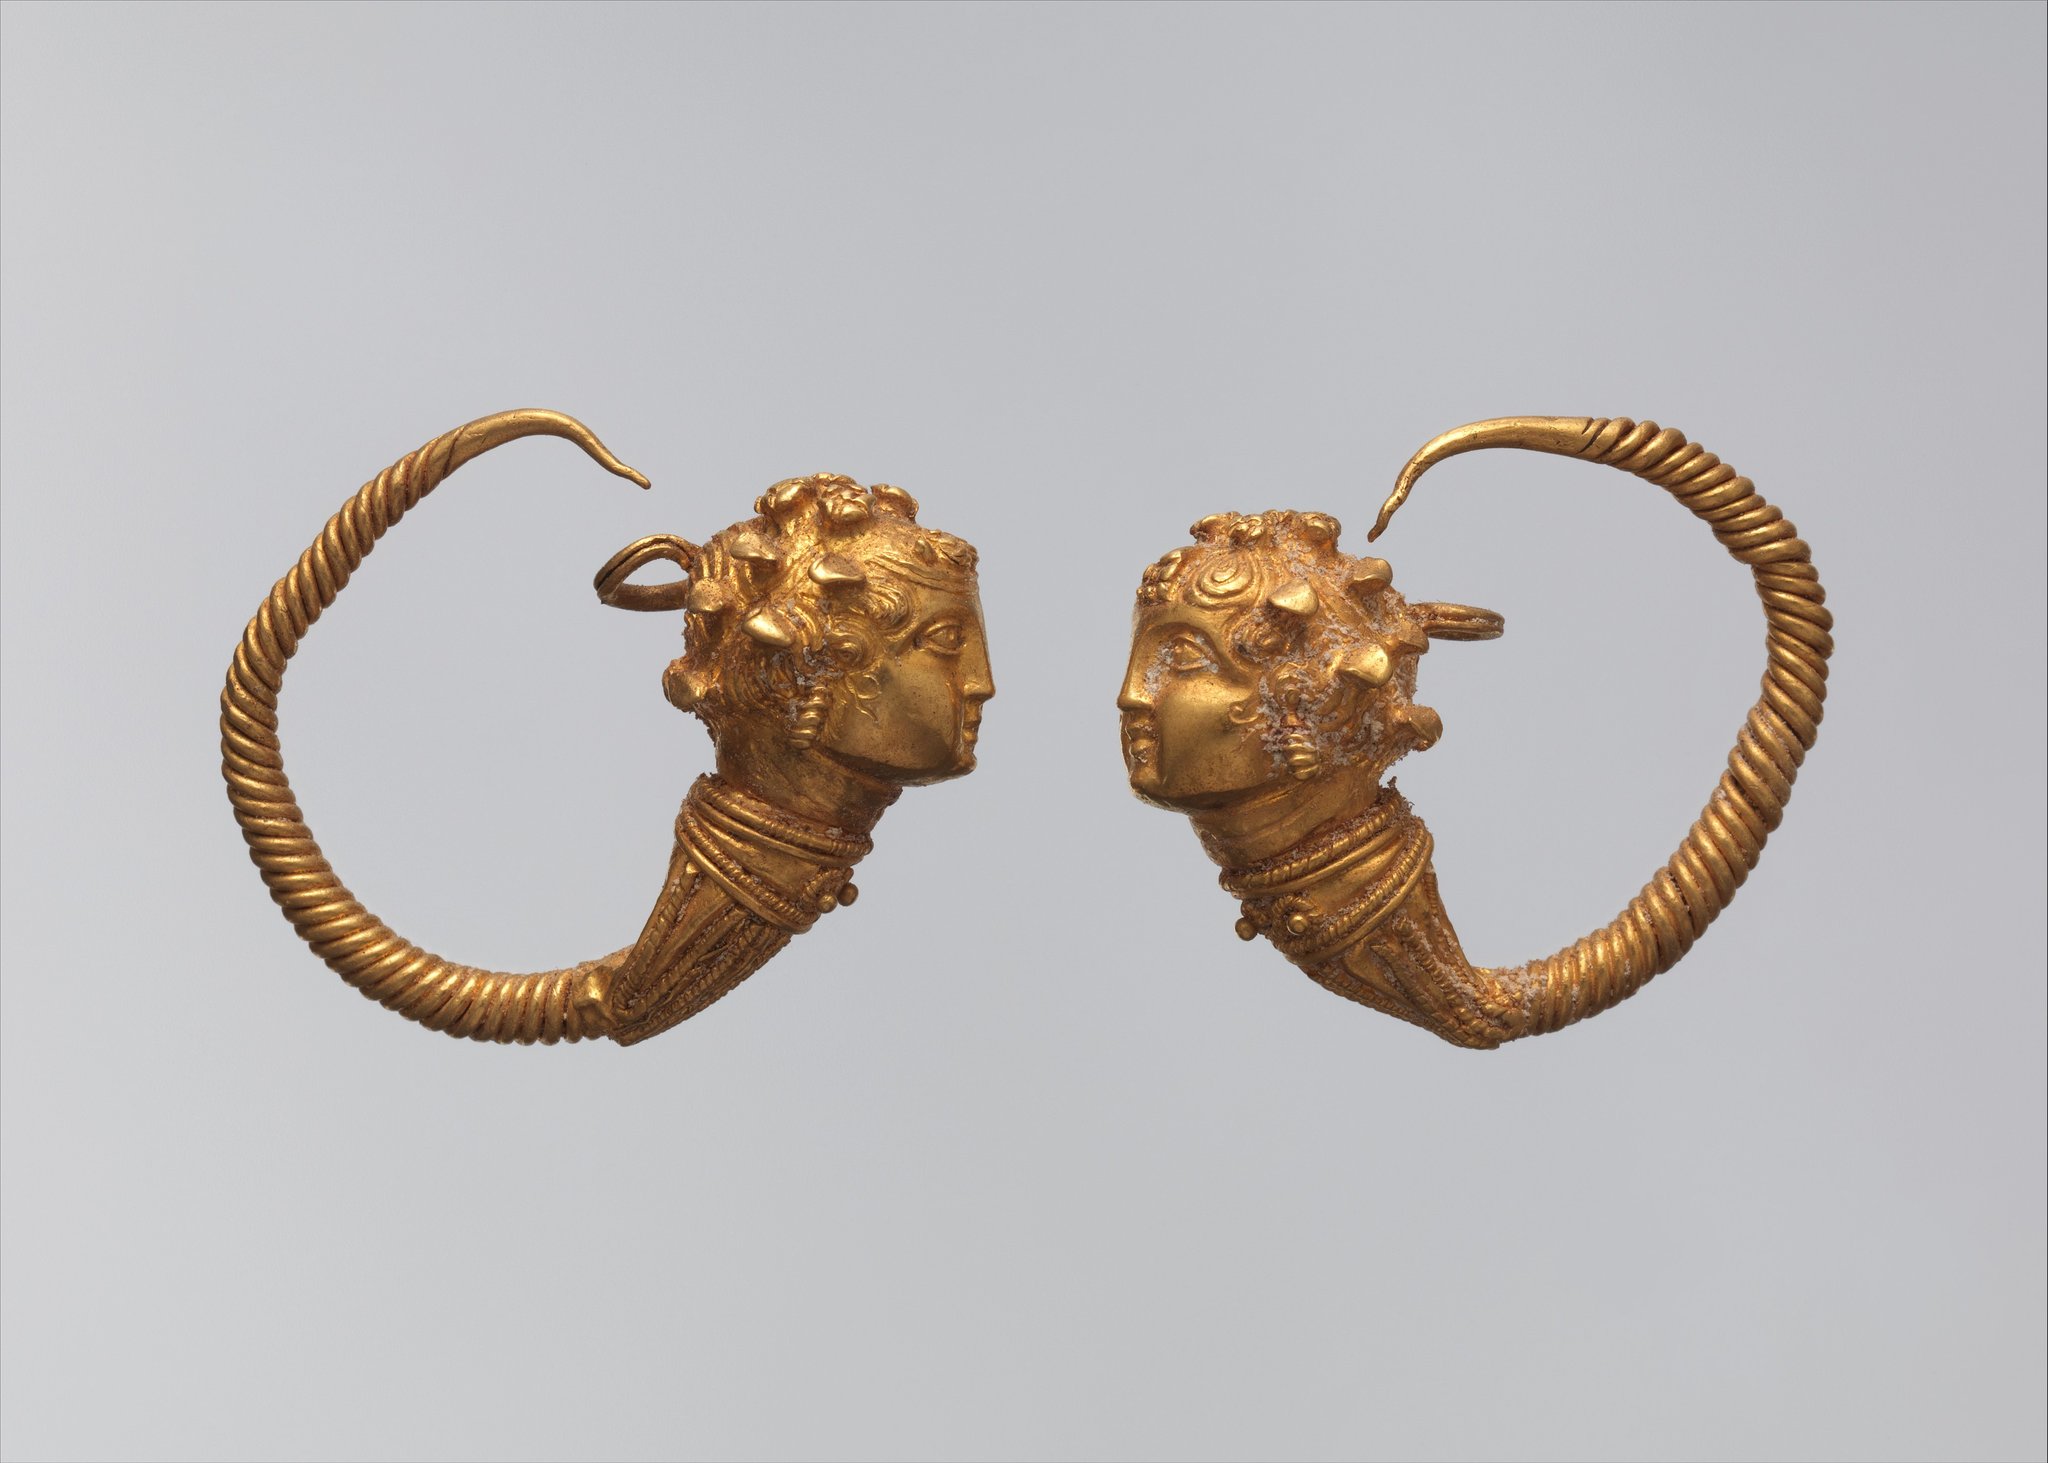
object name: earring, maenad head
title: Maenad-head earrings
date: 100-1 BCE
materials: gold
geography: egypt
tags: maenads